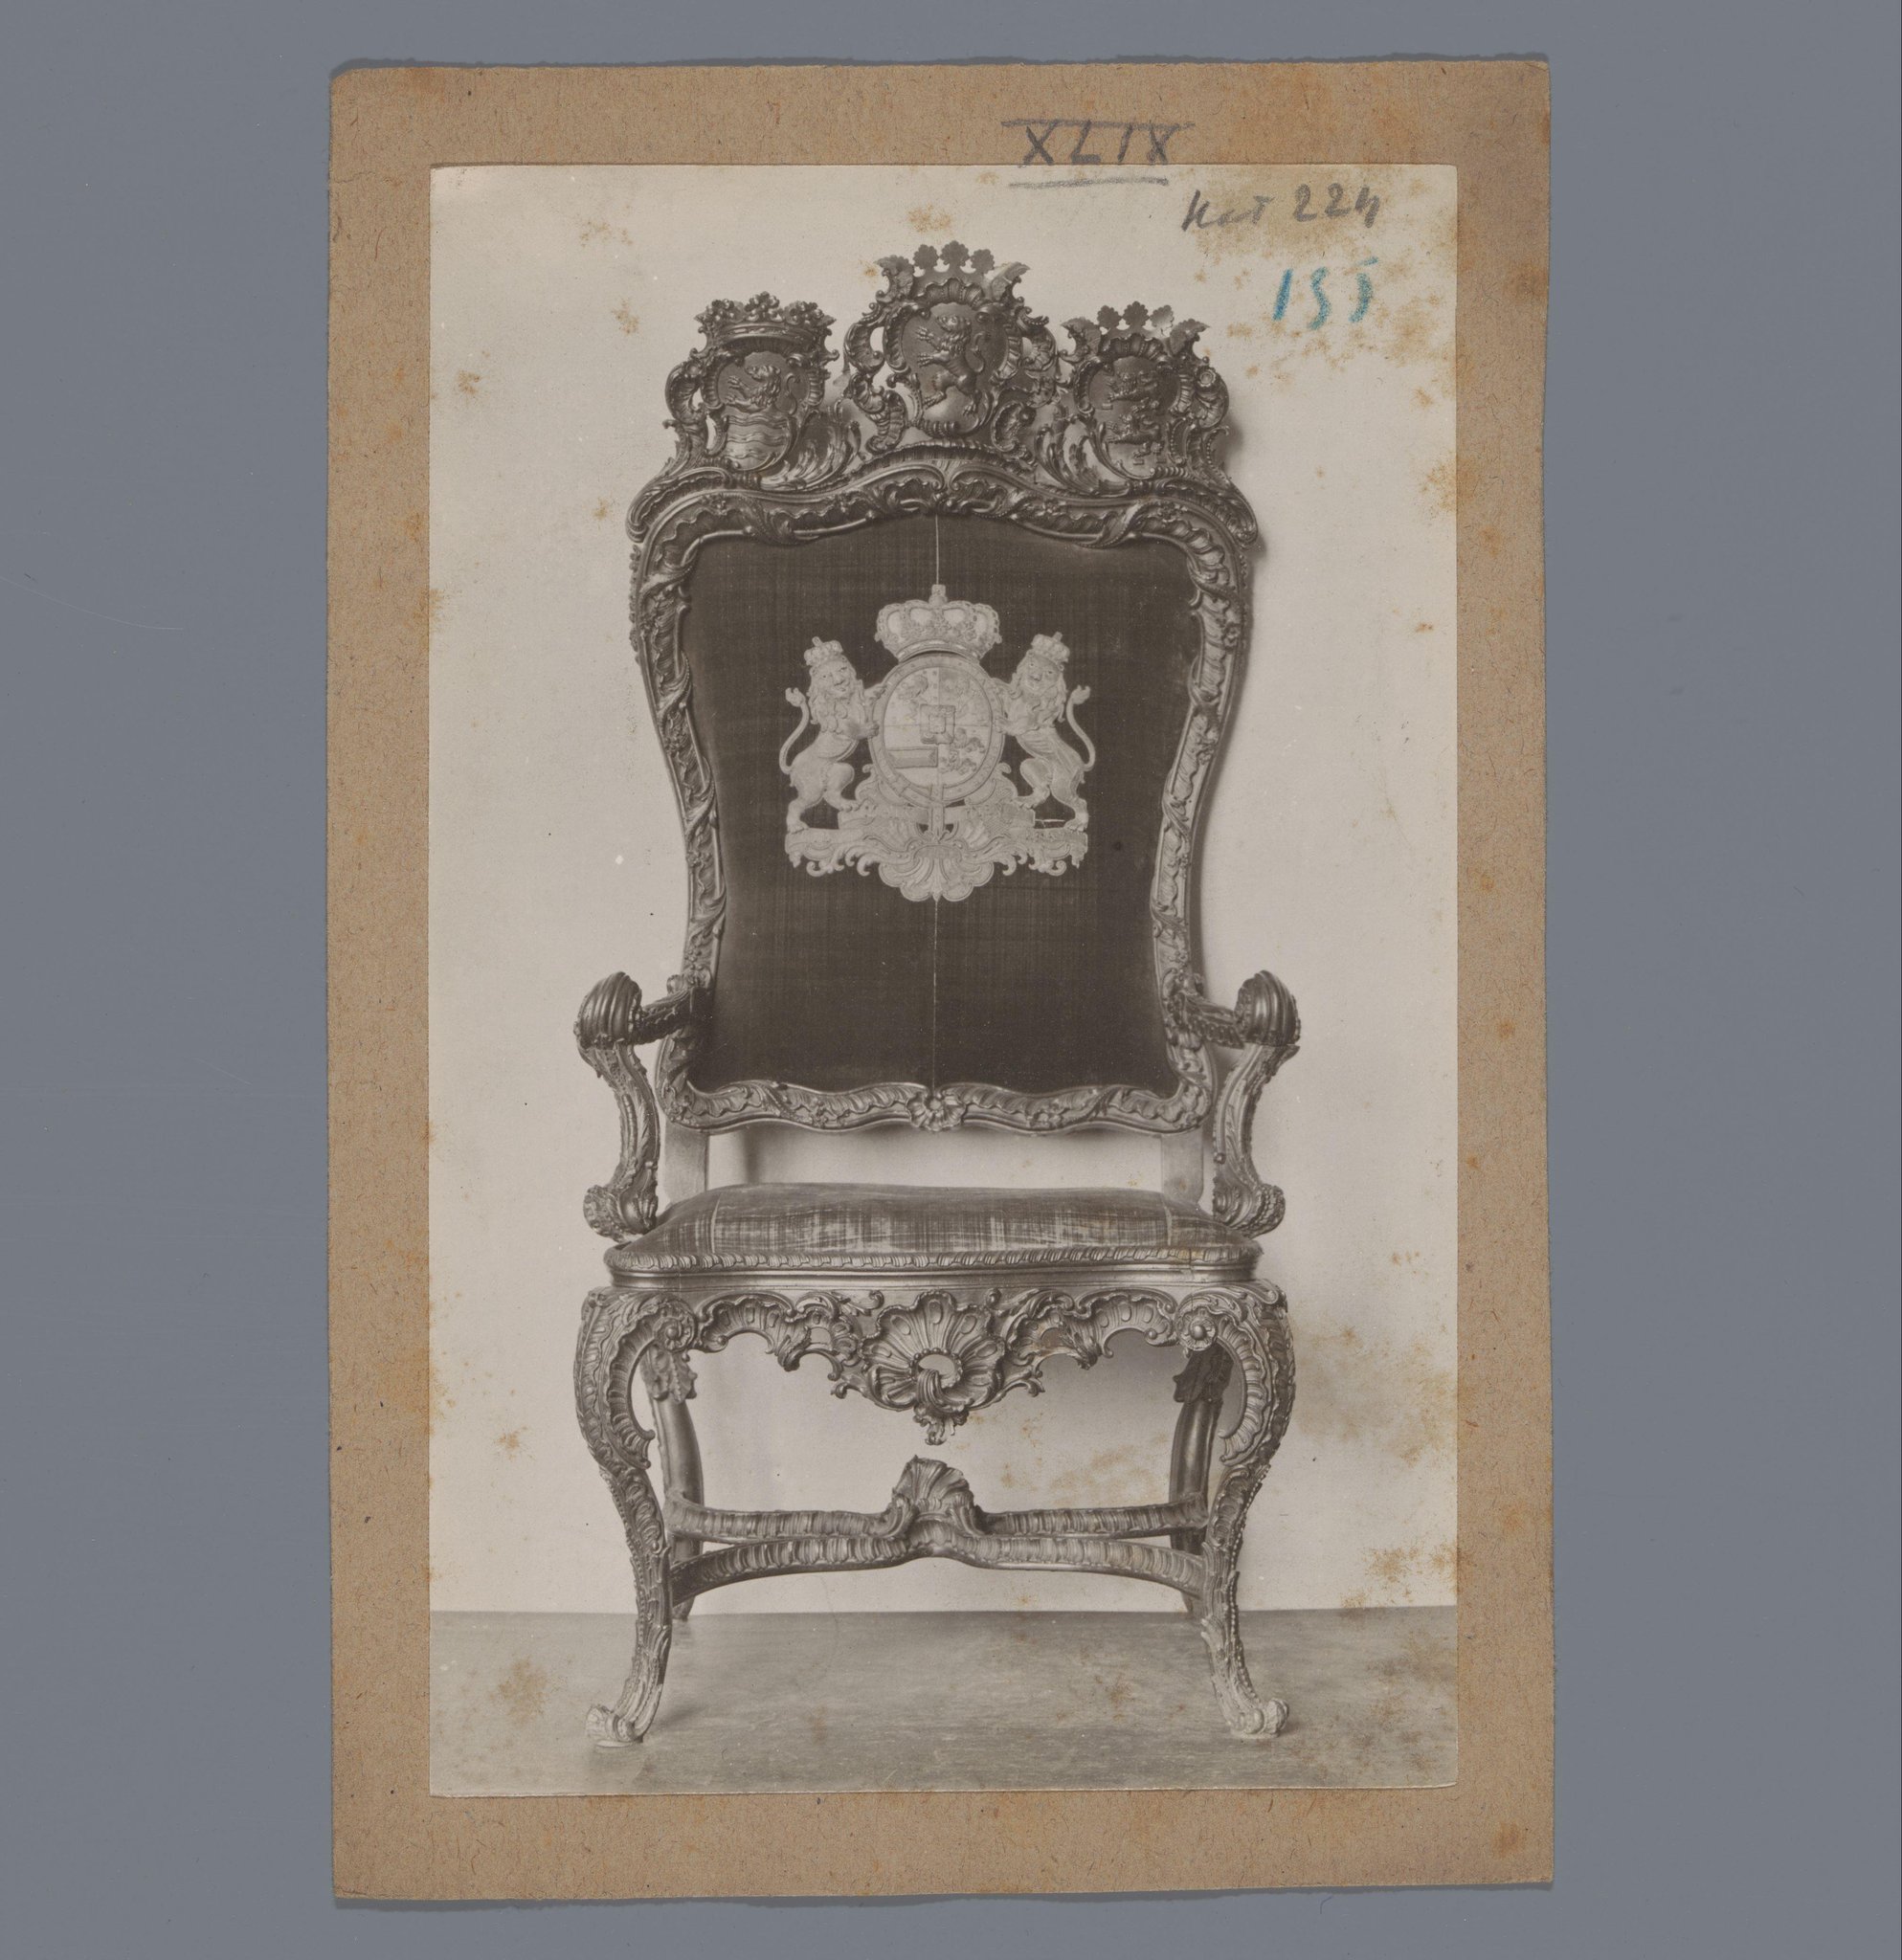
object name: photograph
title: Armstoel gedecoreerd met wapenschilden (vermoedelijk) in het Rijksmuseum te Amsterdam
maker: Anonymous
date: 1875-1900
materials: photographic support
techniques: matte daylight collodion silver print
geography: amsterdam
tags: coat of arms (as symbol of the state, etc.), chair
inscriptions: number: ‘XLIX kat. 224 135’, collector's mark: ‘Instituut voor kunst-nijverheidsonderwijs Gabriël Metsustraat No. 16, Amsterdam’, collector's mark: ‘Kunstnijverheidschool Quellinus Amsterdam Frans Halsstraat 14.’